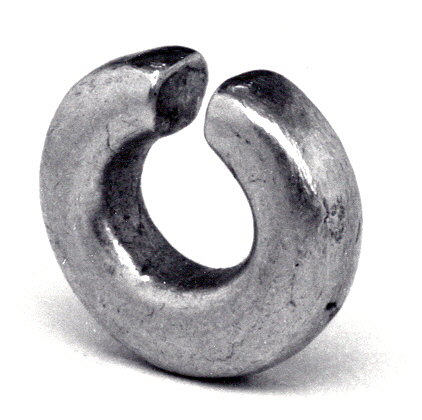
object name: nose ornament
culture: calima or yotoco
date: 1-700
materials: gold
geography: colombia